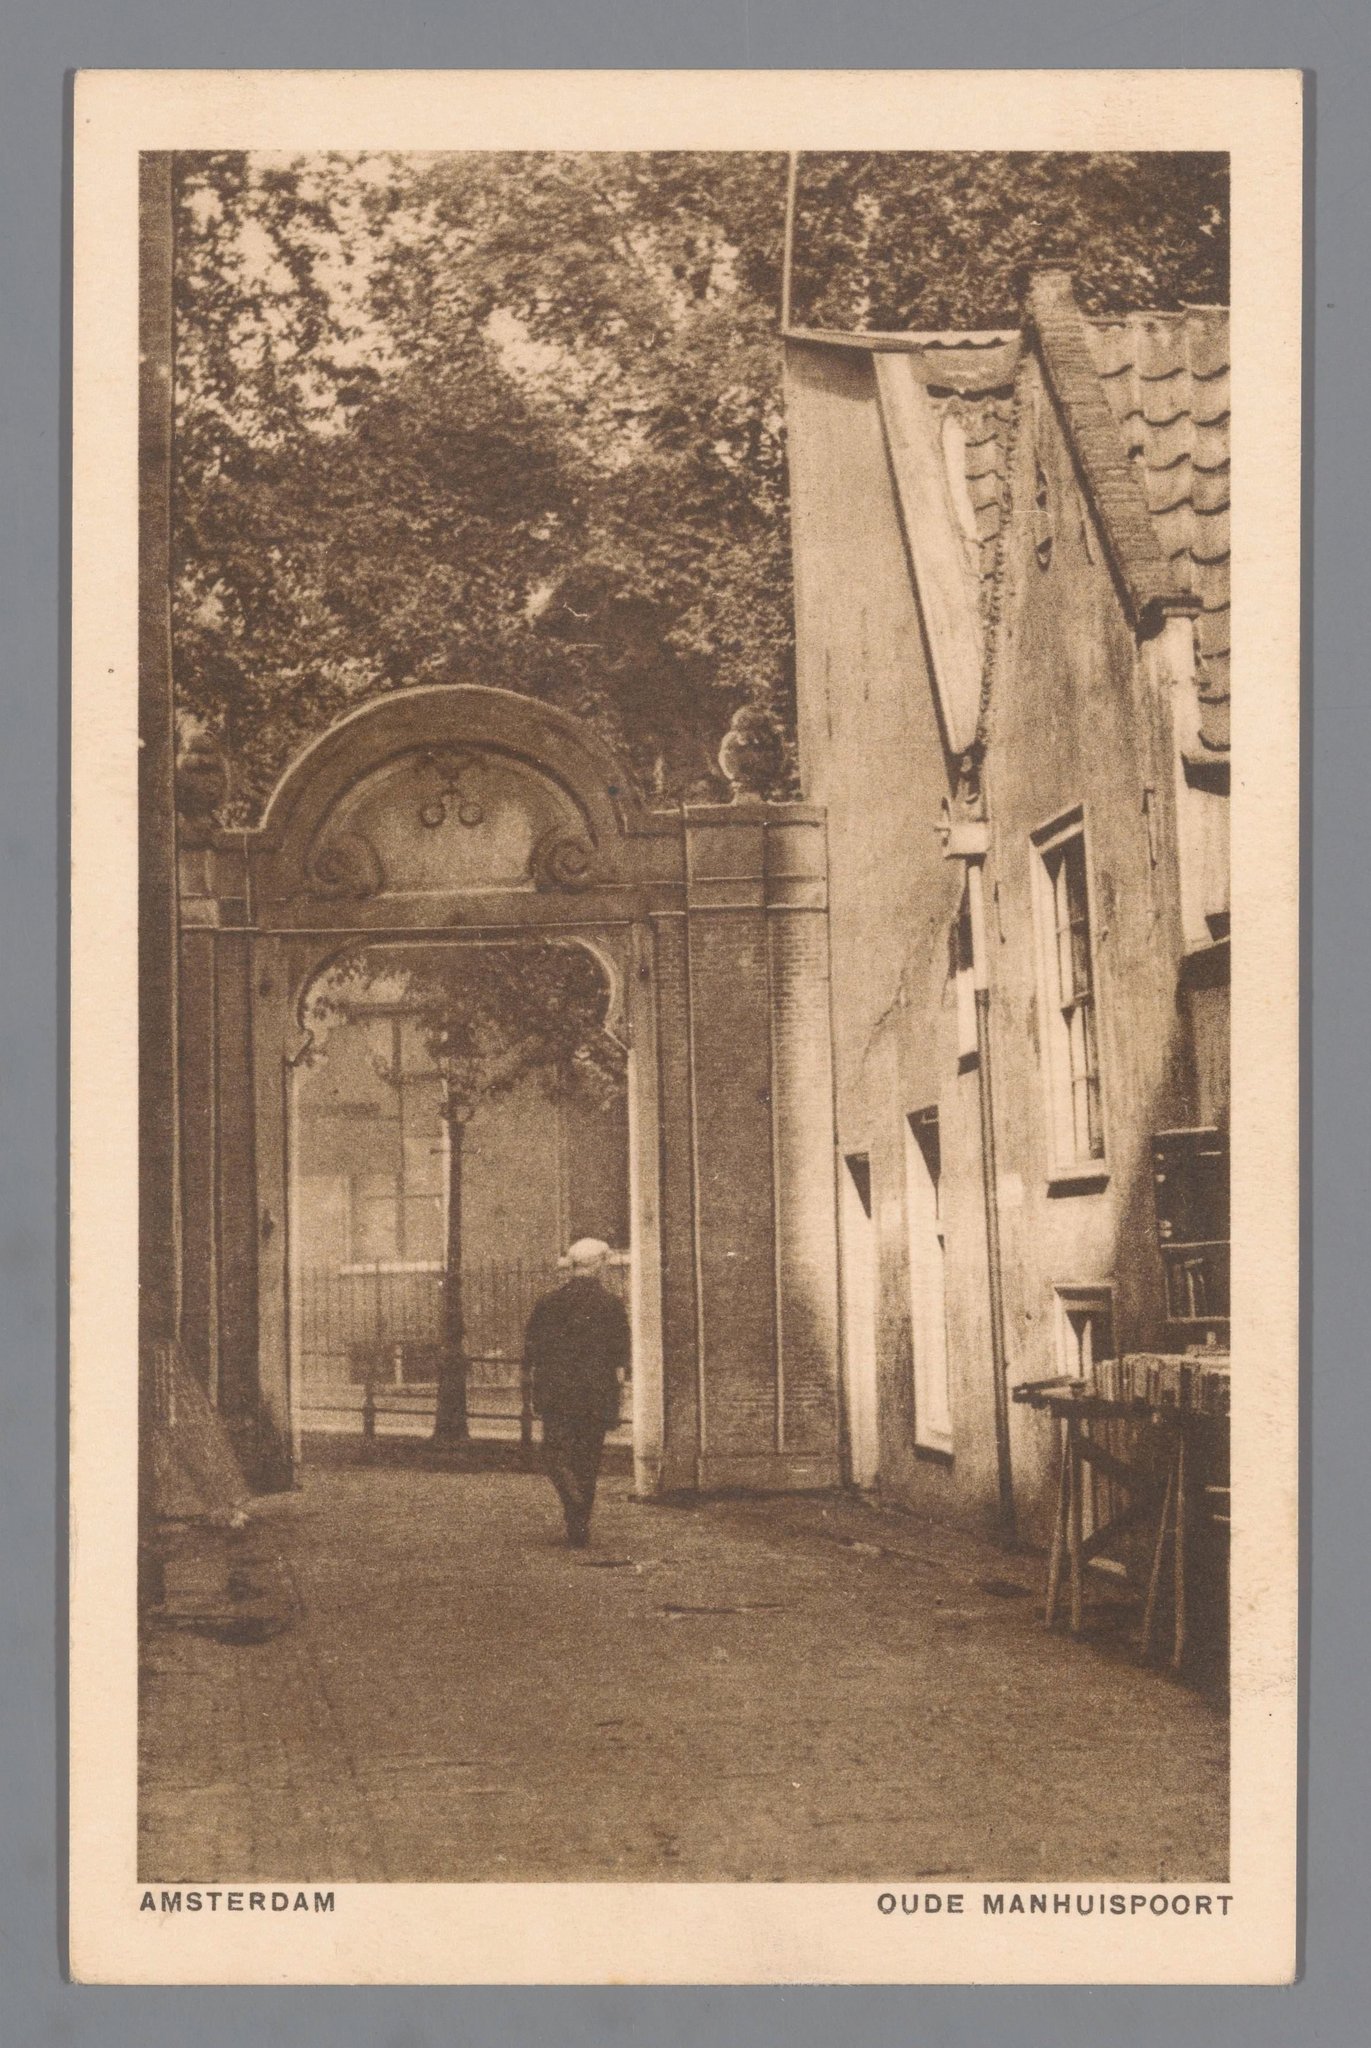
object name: photomechanical print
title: Amsterdam, Oude Manhuispoort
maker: Anonymous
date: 1875-1930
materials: paper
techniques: photograph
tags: gate, entrance